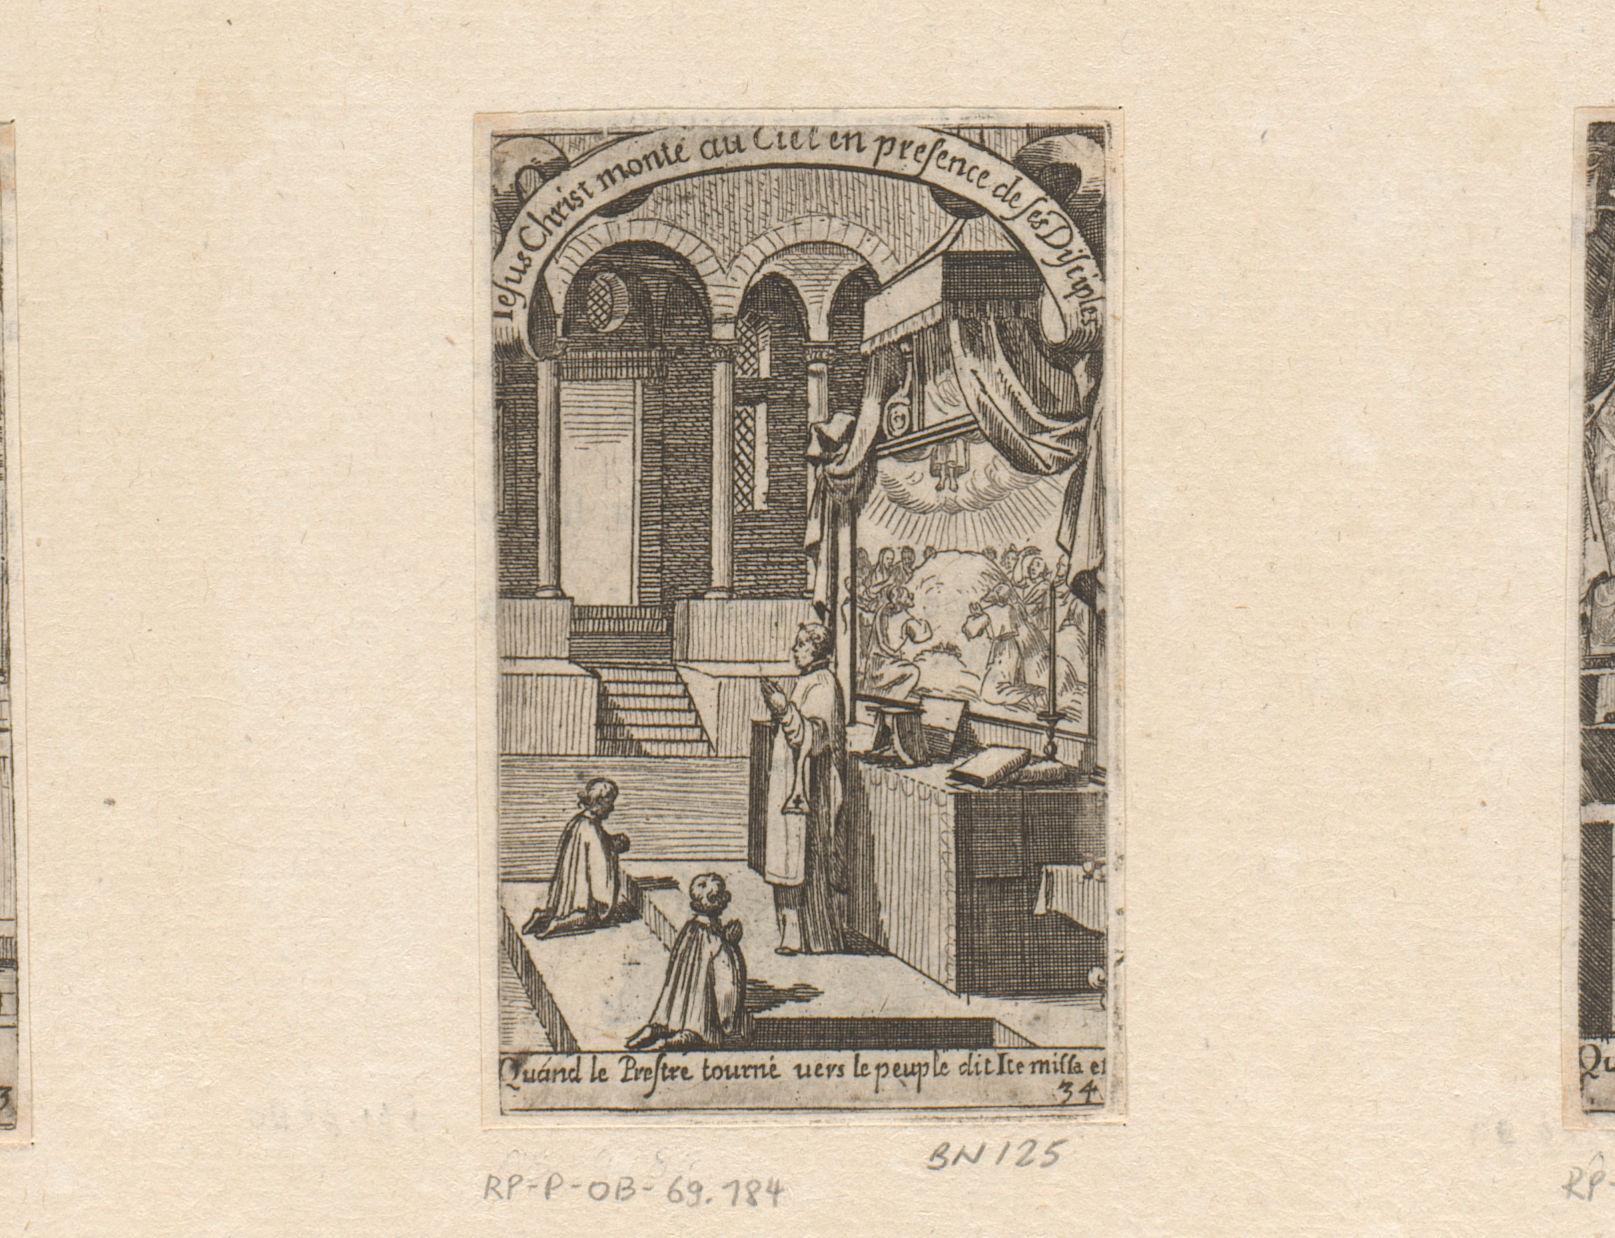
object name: print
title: Quand le Prestre tourné vers le peuple dit Ite missa est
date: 1661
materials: paper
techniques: etching, letterpress printing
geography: france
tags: priest (roman catholic), altar with altar-piece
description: Prent uit: Mengin, L. Tableaux ou sont representees la passion de N.S. Christ et les actions du prestre a la S. Messe (...). Metz: Claude Bouchard, 1661.